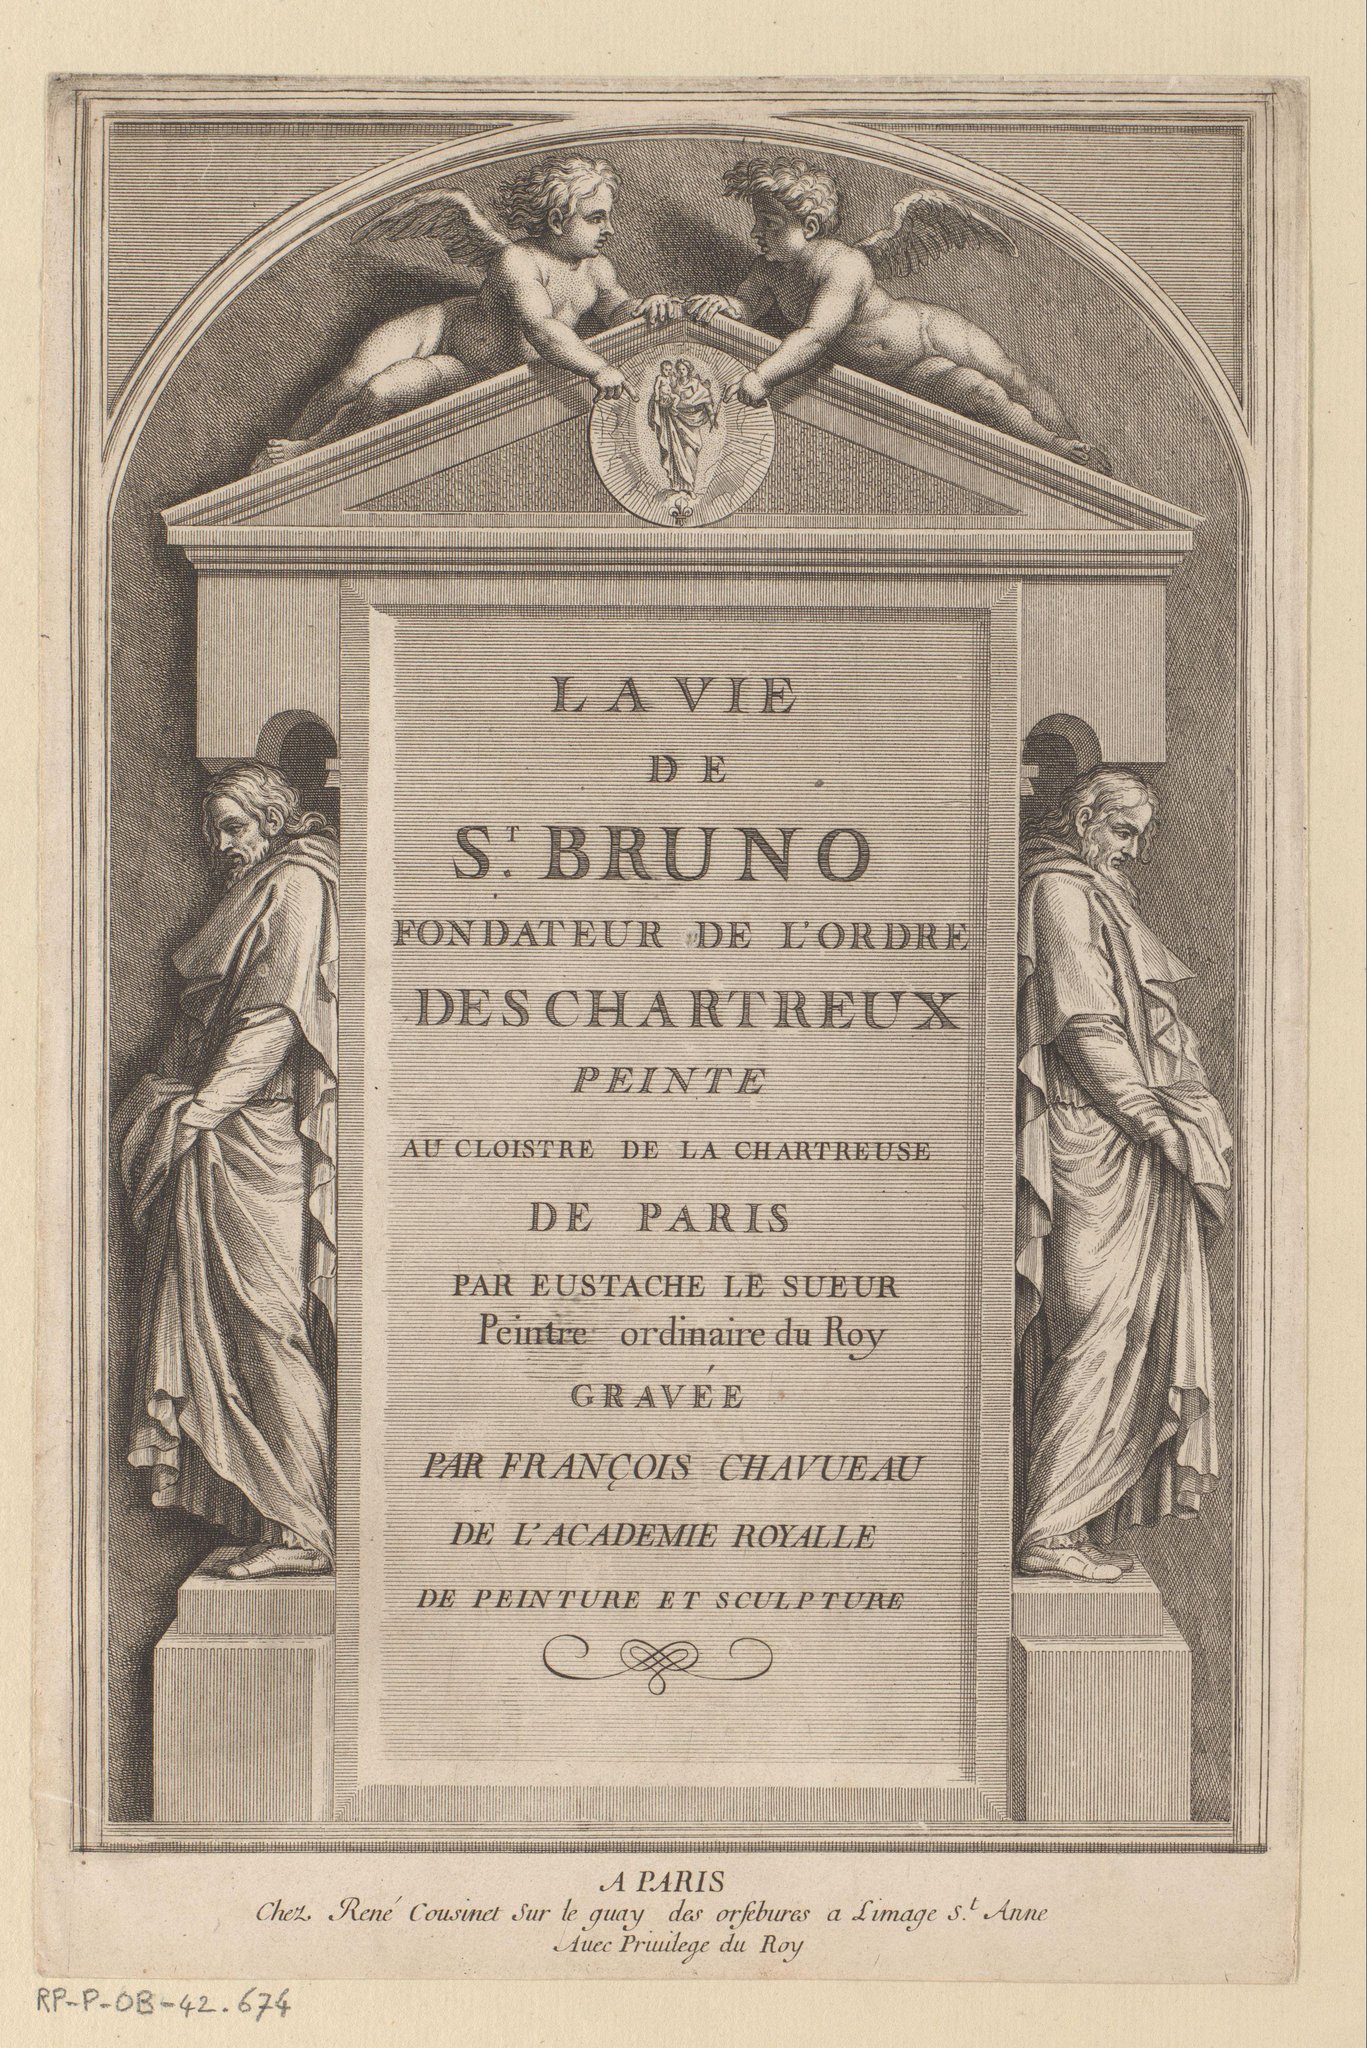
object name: titelprent, frontispice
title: Titelprent met twee mannelijke figuren naast een gedenkplaat met bovenop putti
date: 1623-1676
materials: paper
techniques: etching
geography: paris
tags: the founder of the order of the carthusians, bruno; possible attributes: cross, finger at lips, lily, mitre at his feet, olive-branch, ray of light, skull, (seven) star(s), cupids: 'amores', 'amoretti', 'putti'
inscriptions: collector's mark: Lugt 2165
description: Maakt deel uit van een serie met 24 prenten (inclusief twee titelprenten), naar schilderijen door Lesueur vervaardigd tussen 1645-1648 voor de Chartreuse de Paris. De serie is getiteld: La vie de St. Bruno fondateur de l'Ordre des Chartreux peinte au cloistre de la Chartreuse de Paris par Eustache Le Sueur en werd uitgegeven door René Cousinet.